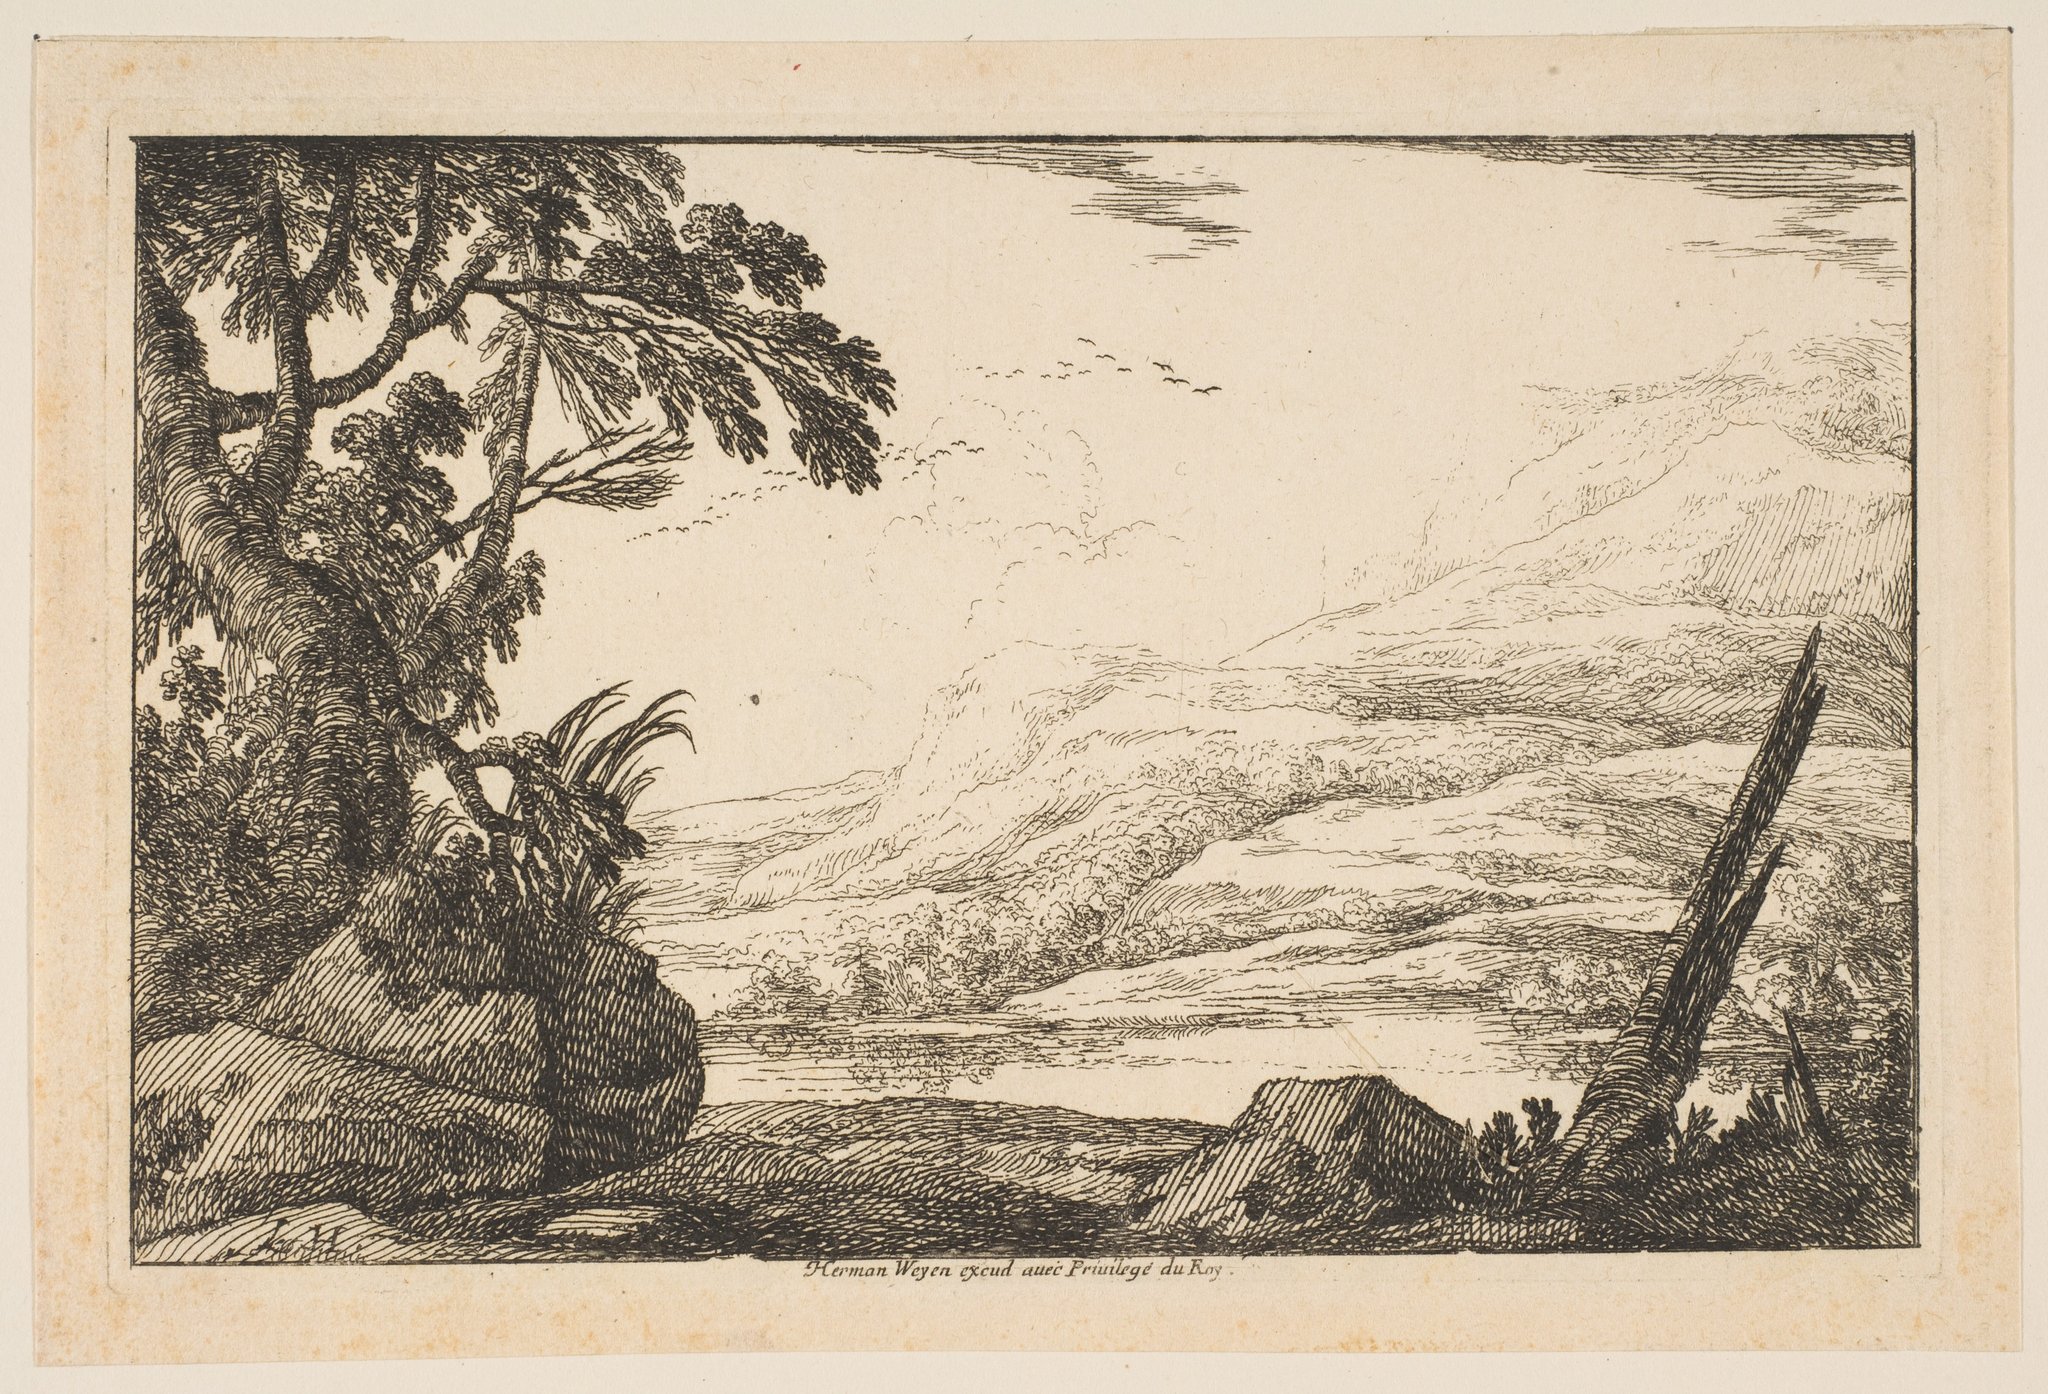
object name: print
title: Clump of Trees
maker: laurent de la hyre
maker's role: artist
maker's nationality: french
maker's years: 1606-1656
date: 1640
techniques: etching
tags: trees